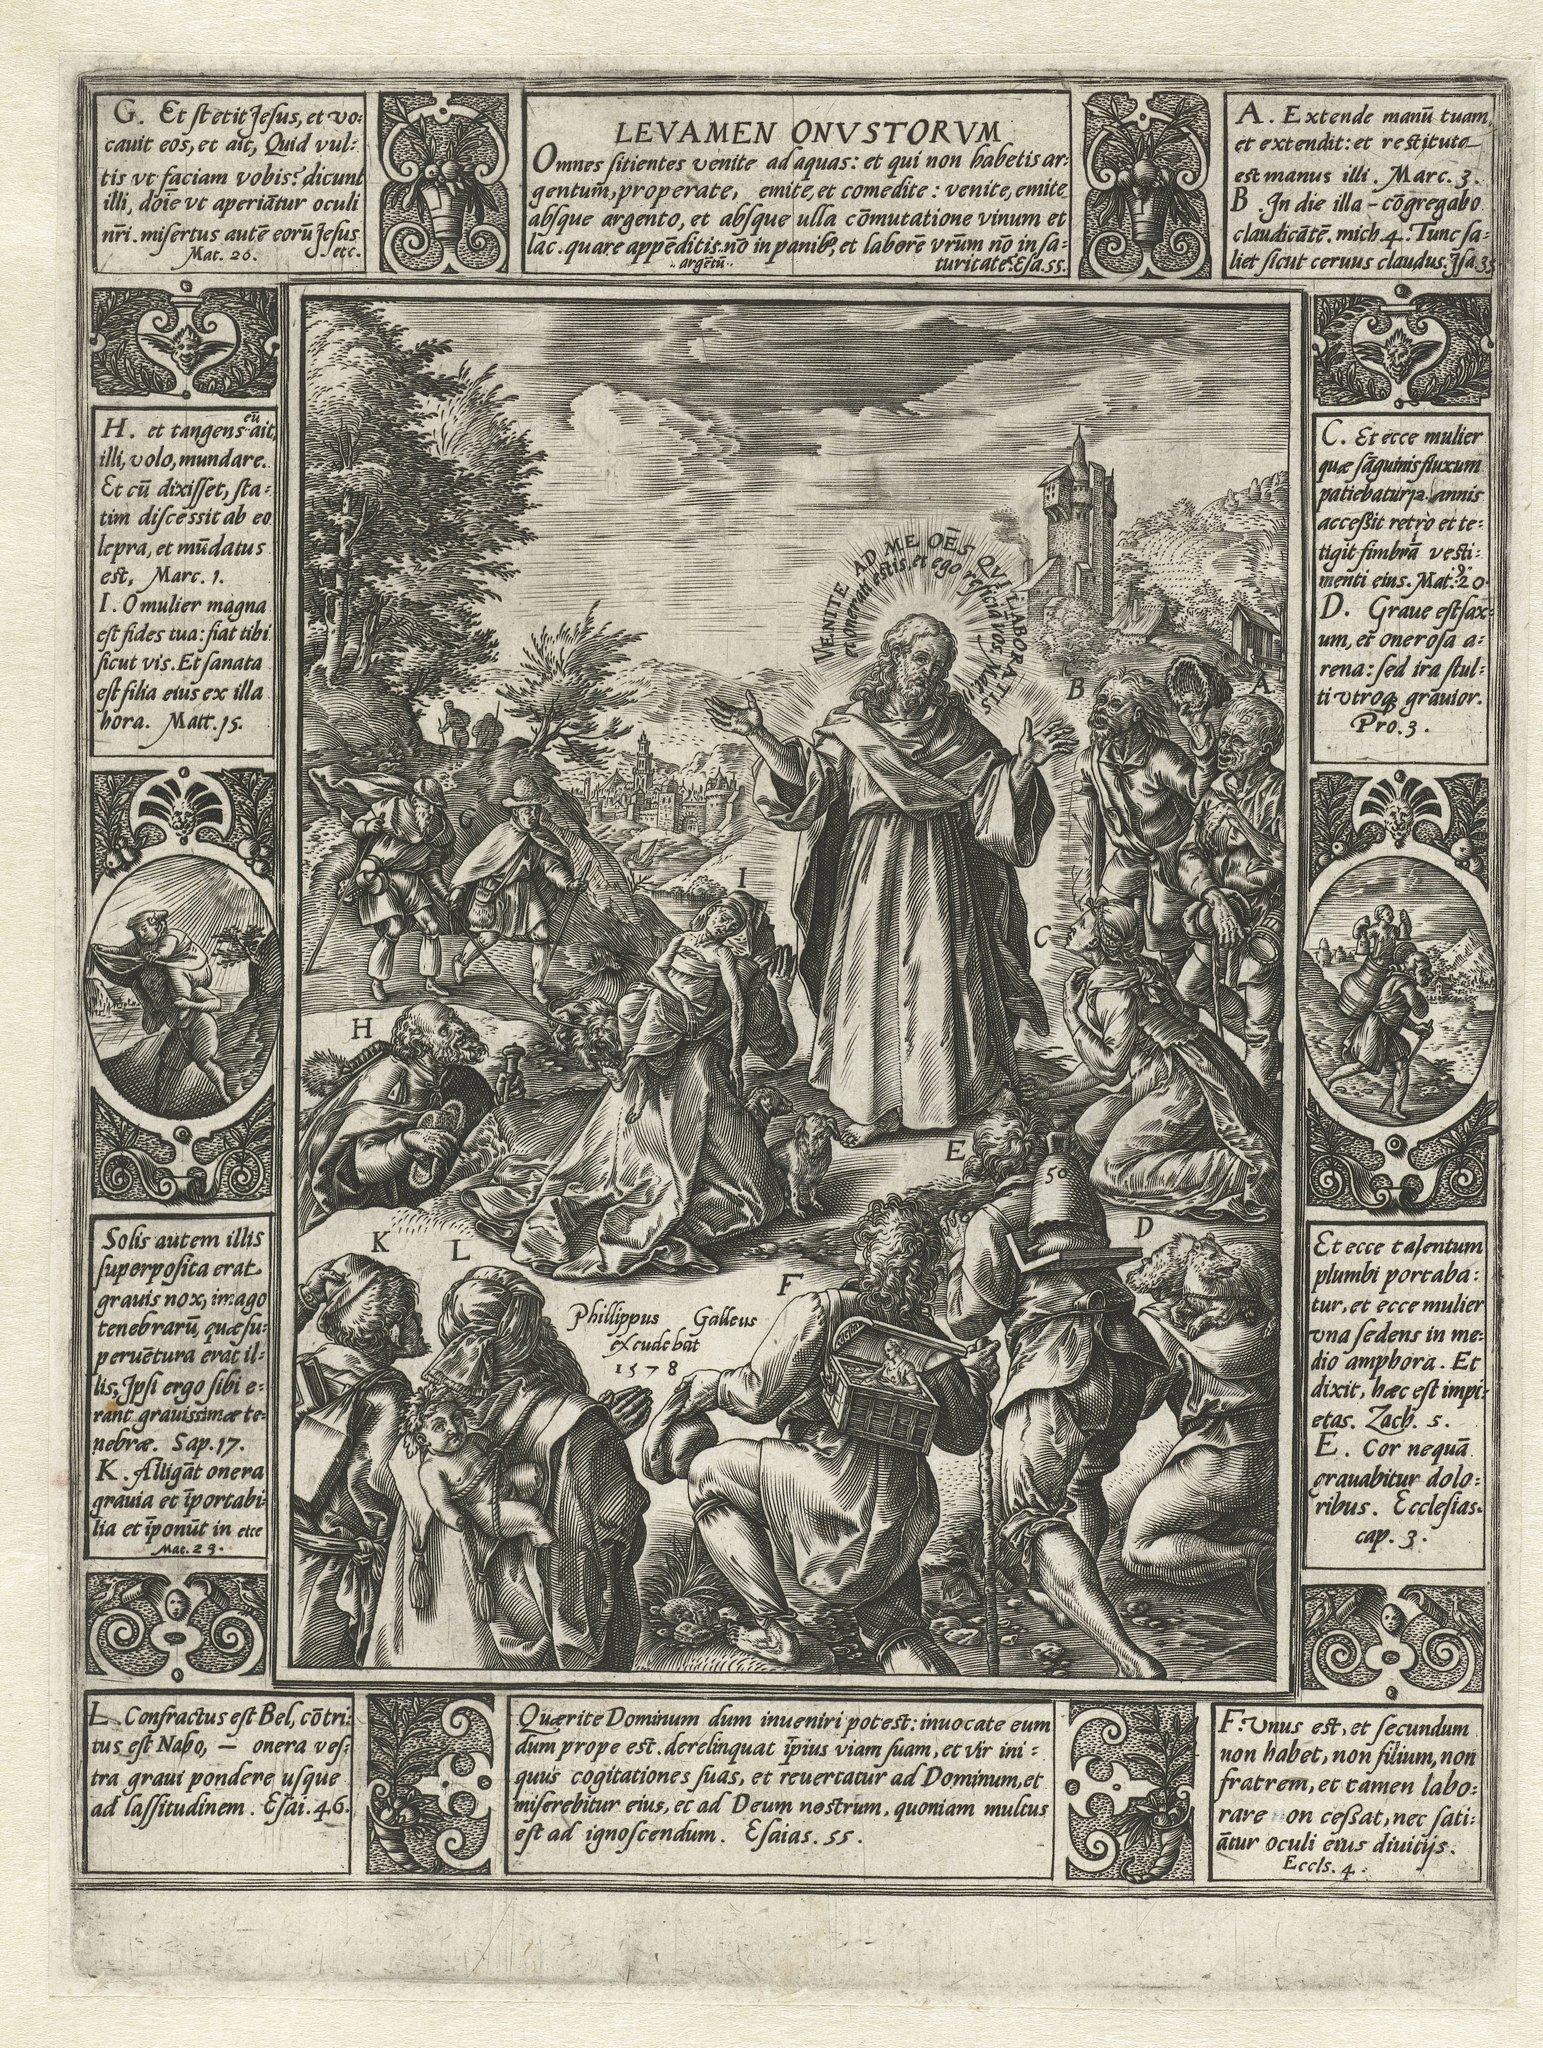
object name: print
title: Allegorieën van het christelijke geloof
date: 1578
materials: paper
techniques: engraving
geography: antwerp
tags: symbols and prefigurations of christ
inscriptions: address: ‘Phillippus Galleus excudebat 1578’, collector's mark: Lugt 2228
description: Serie van twaalf allegorieën van het christelijke geloof. Elk van de allegorieën bestaat uit een centrale voorstelling met daaromheen een omlijsting waarin citaten uit de bijbel gecombineerd zijn met de verbeelding van bepaalde gebeurtenissen uit de bijbel.